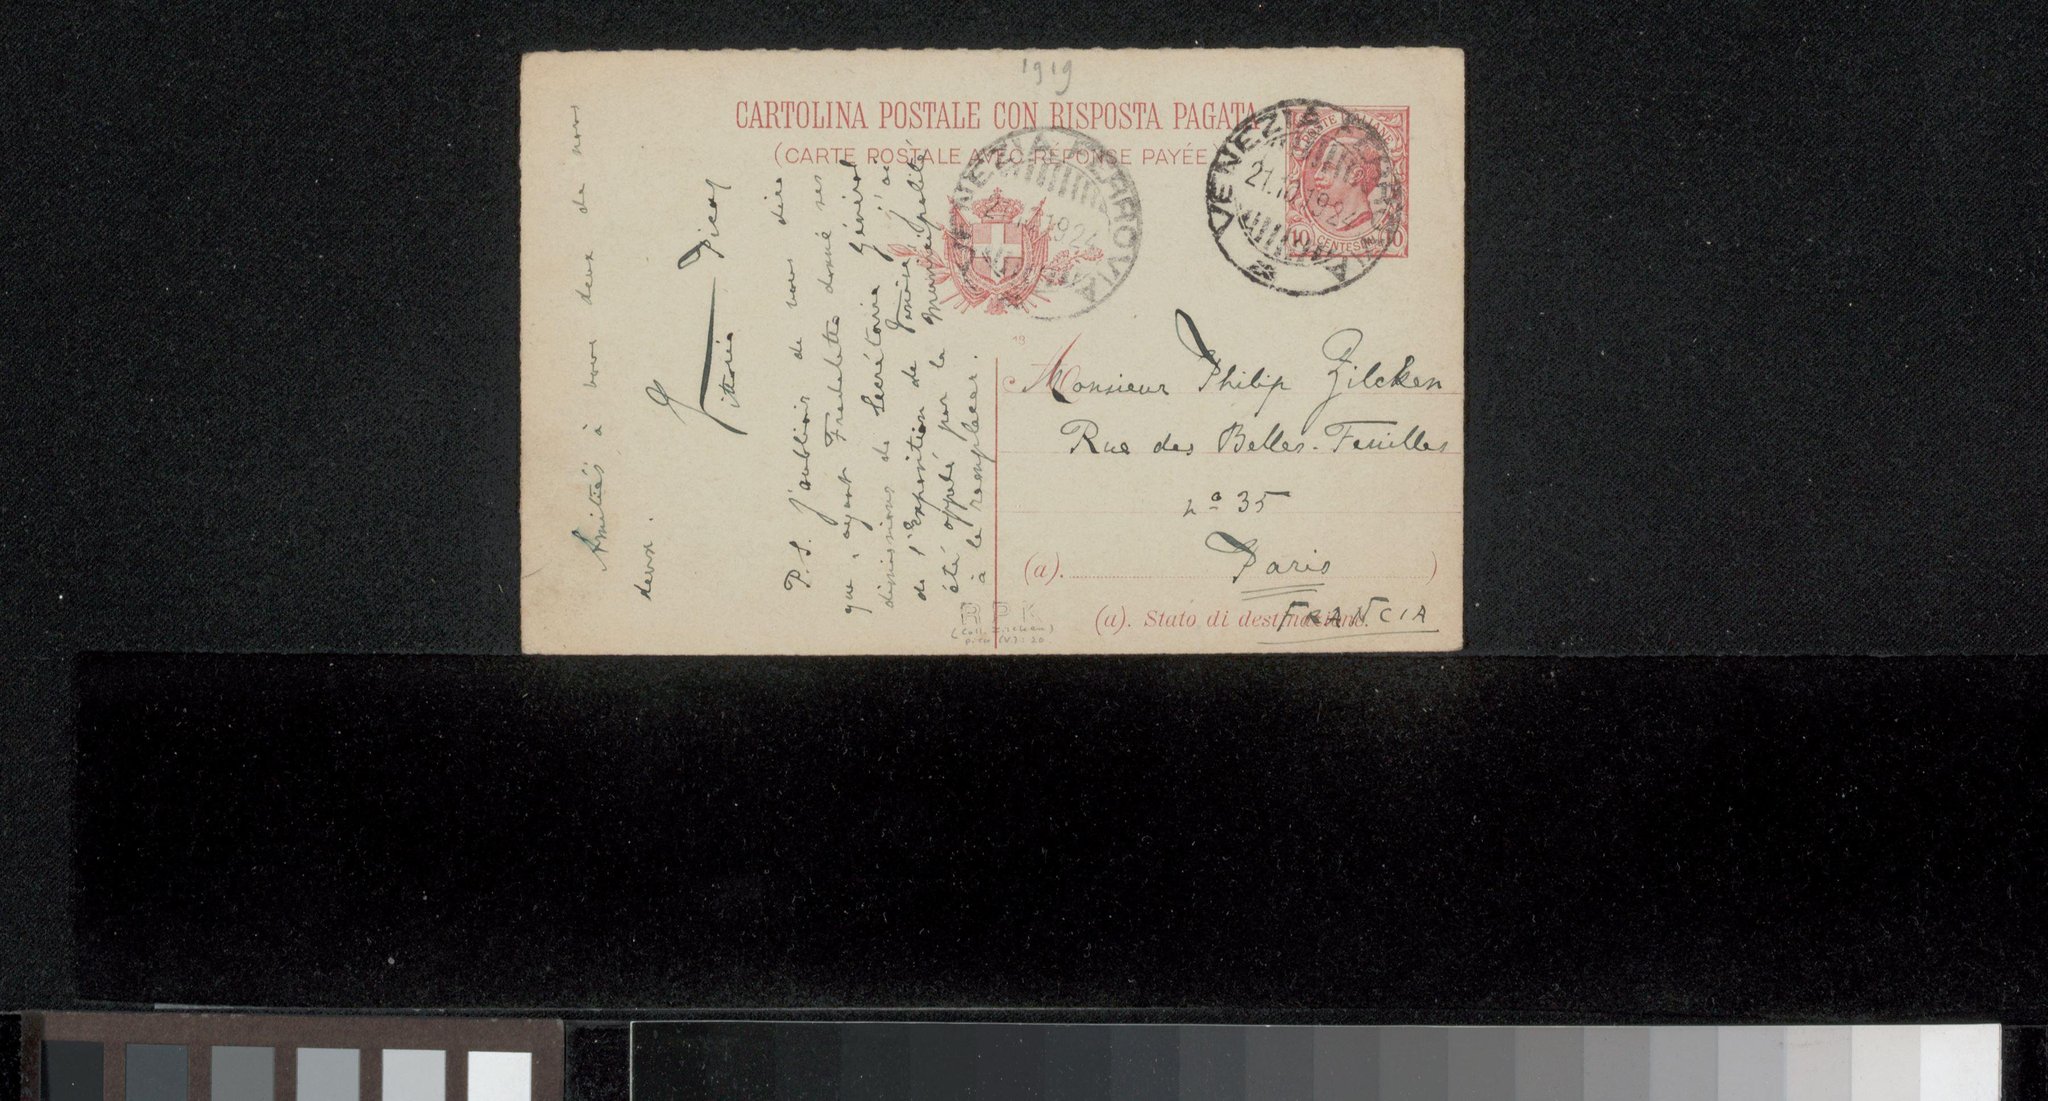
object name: postcard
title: Briefkaart aan Philip Zilcken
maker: vittorio pica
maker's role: criticus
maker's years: 1864-1930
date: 1919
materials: cardboard, ink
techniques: pen, writing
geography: venice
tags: print maker, vincent van gogh, venice, rome, politician, antonio fradeletto, the hague, painter, draughtsman, ernst van der minne, philip zilcken, exhibition ~ art, paris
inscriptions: collector's mark: ‘RPK’